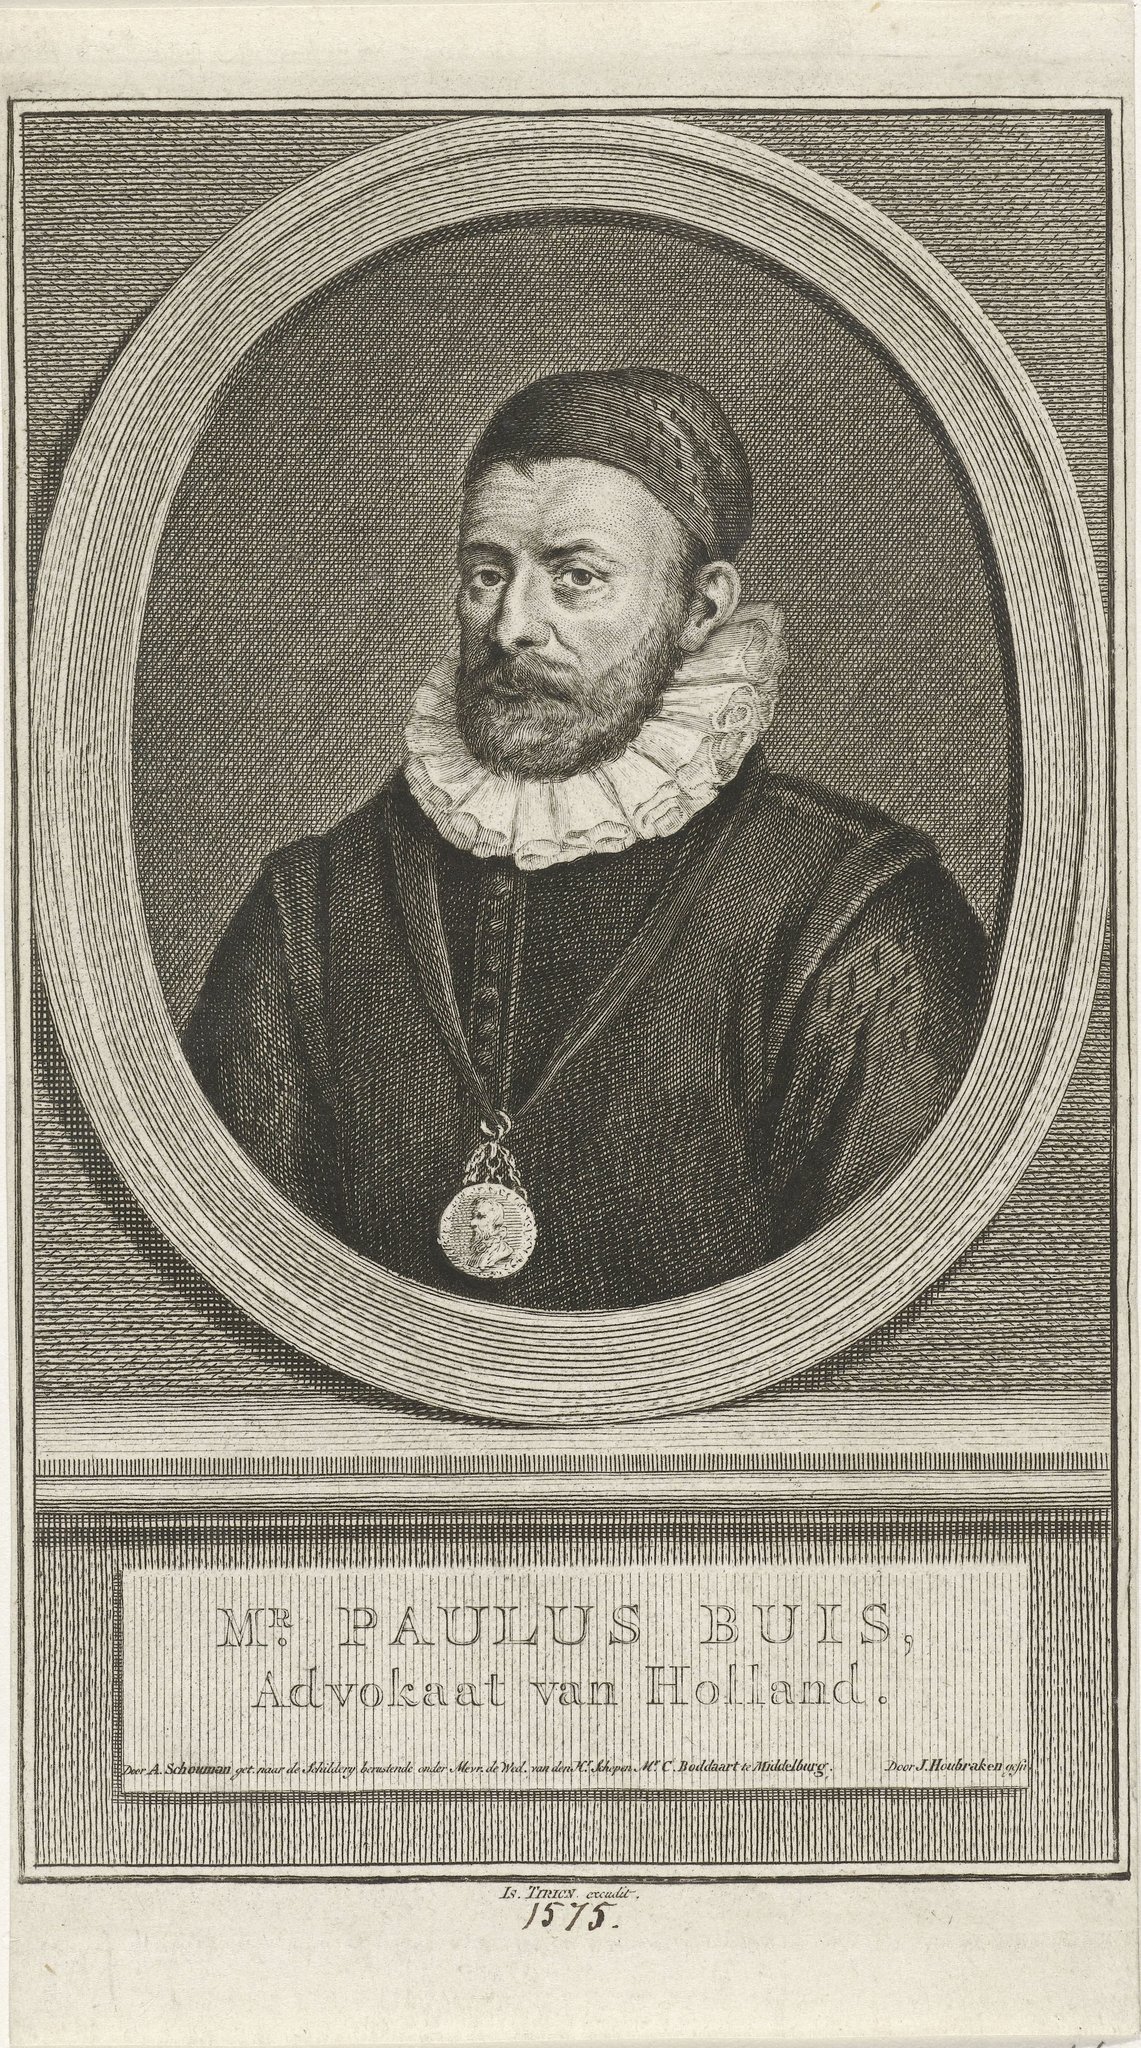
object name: print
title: Mr. Paulus Buis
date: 1749-1759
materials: paper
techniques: engraving, pen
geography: amsterdam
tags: amersfoort, ijsselstein, rechtsgeleerde, paulus buys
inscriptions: collector's mark: Lugt 2228, inscription: ‘1575’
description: Prent ook gebruikt in: Jan Wagenaar, Vaderlandsche historie, vervattende de geschiedenissen der nu Vereenigde Nederlanden, inzonderheid die van Holland (...), 21 delen. Amsterdam, Isaak Tirion, 1749-59.